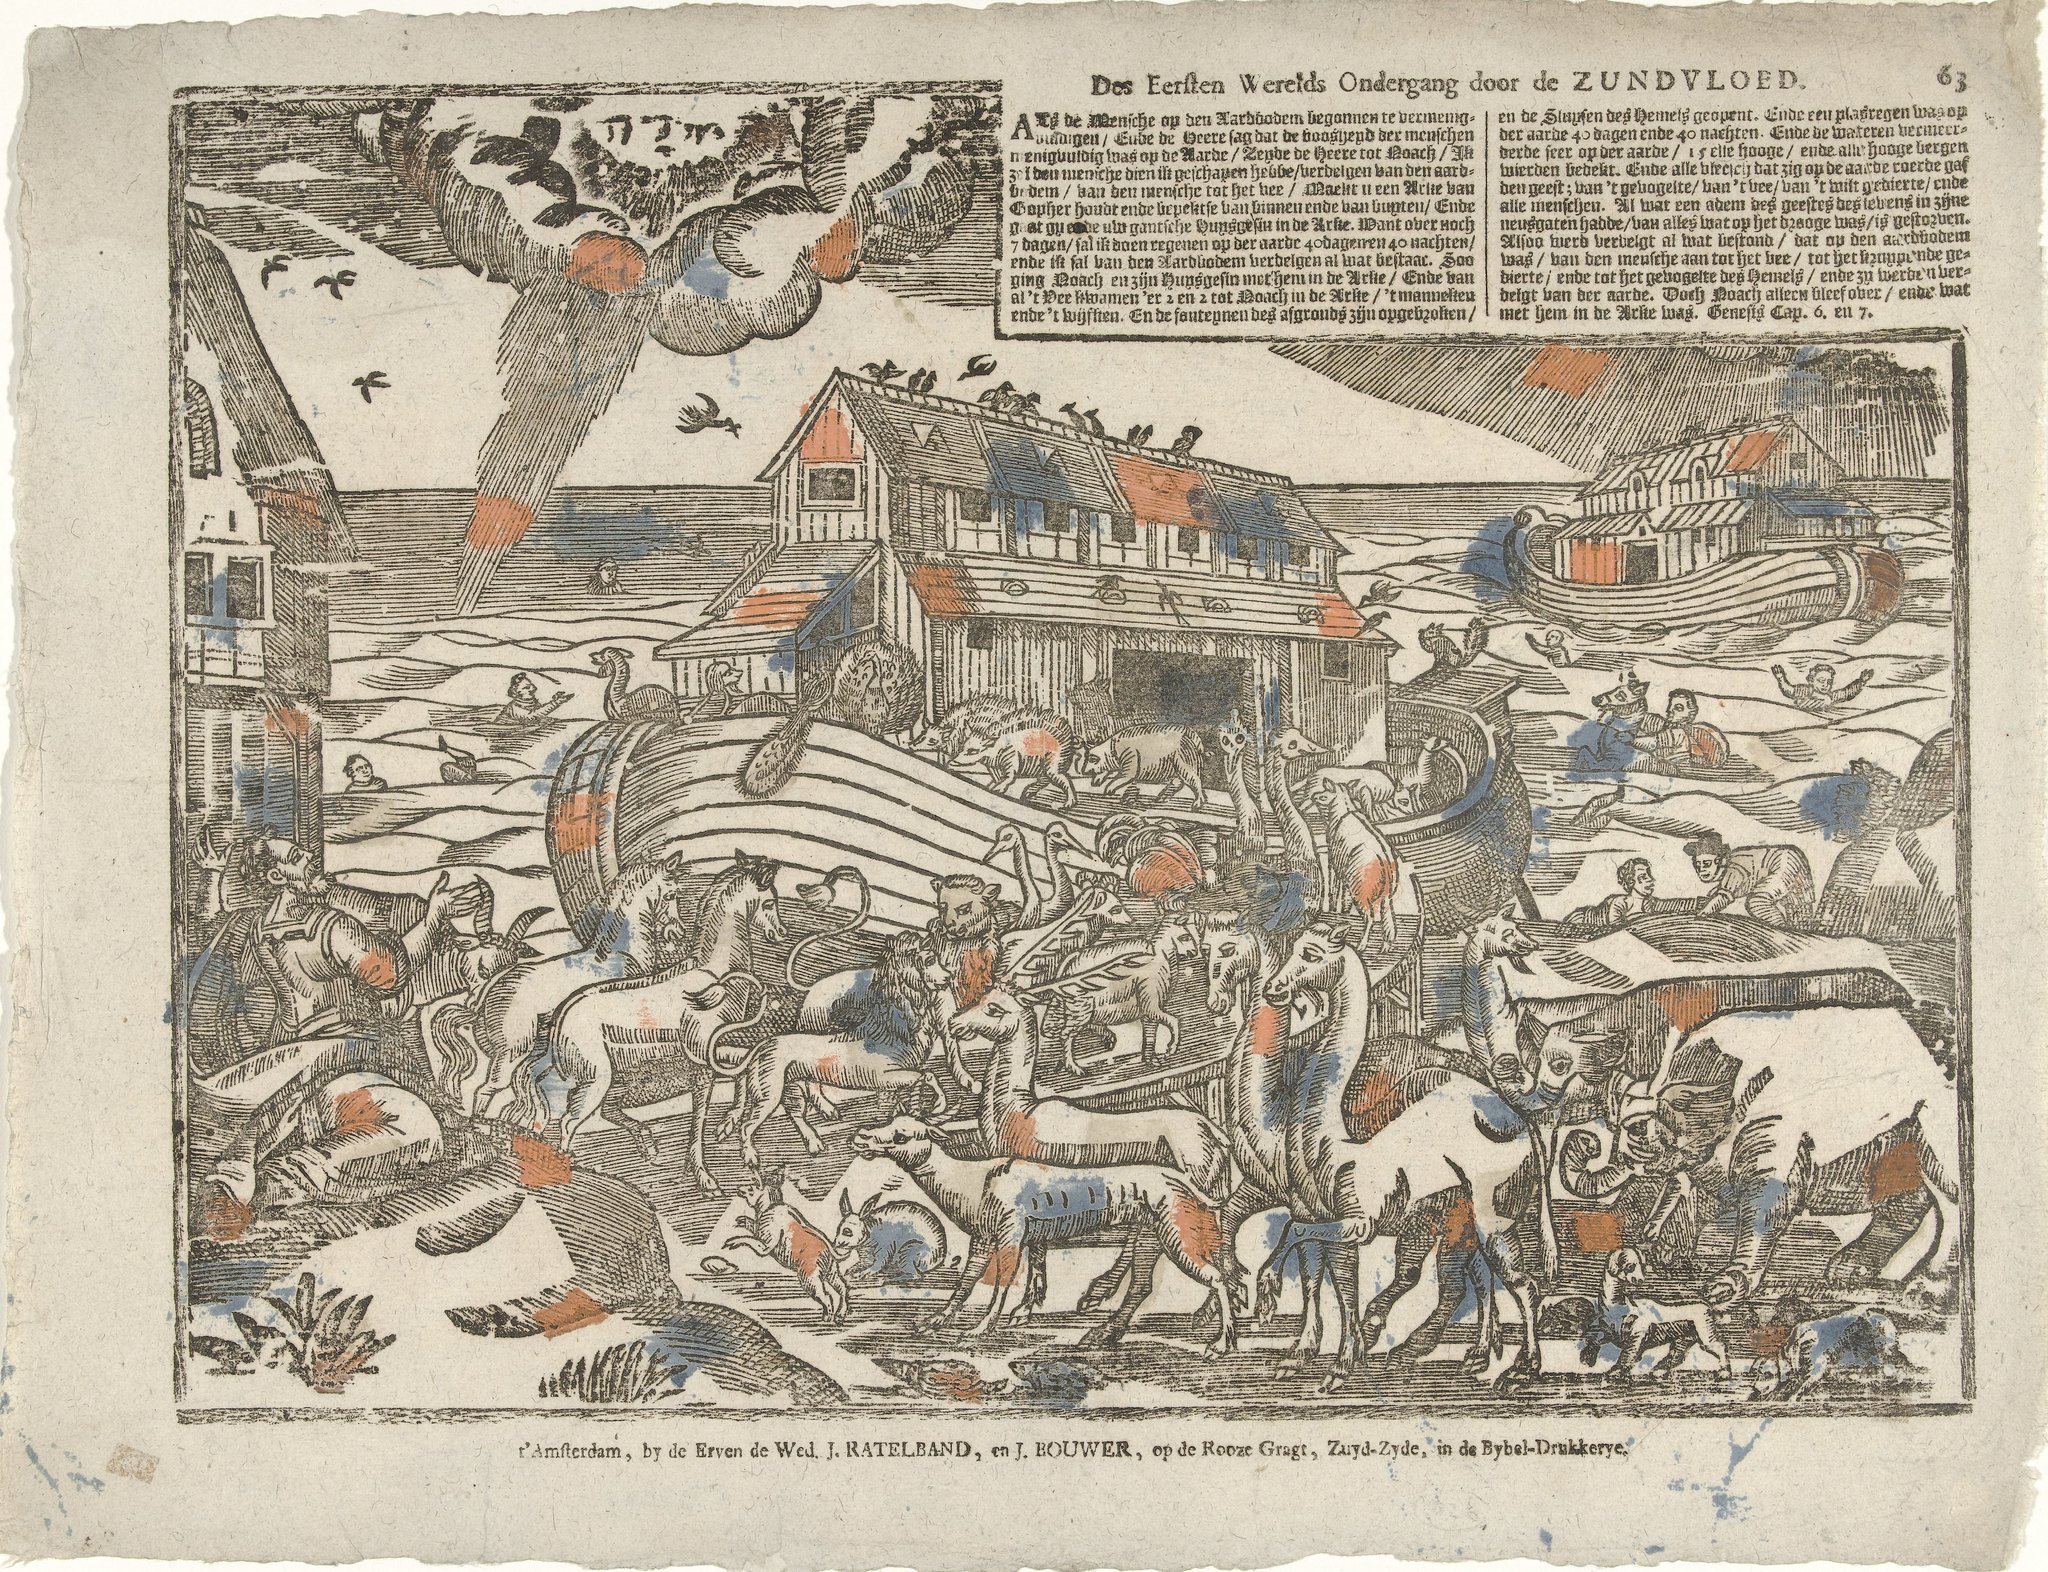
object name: popular print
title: Des eersten werelds ondergang door de zundvloed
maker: Anonymous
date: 1550-1650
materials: paper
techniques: colour, letterpress printing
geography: netherlands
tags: the flood and destruction of mankind ~ story of noah (genesis 7:10 - 8:17), the building of the ark, and the embarkation (genesis 7:5-9)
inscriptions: collector's mark: Lugt 2228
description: Blad met een grote voorstelling van dieren die aan boord gaan van de ark van Noach. Op de achtergrond de Zondvloed. Rechtsboven een uitsparing voor twee kolommen tekst uit Genesis 6 en 7. Genummerd rechtsboven: 63.